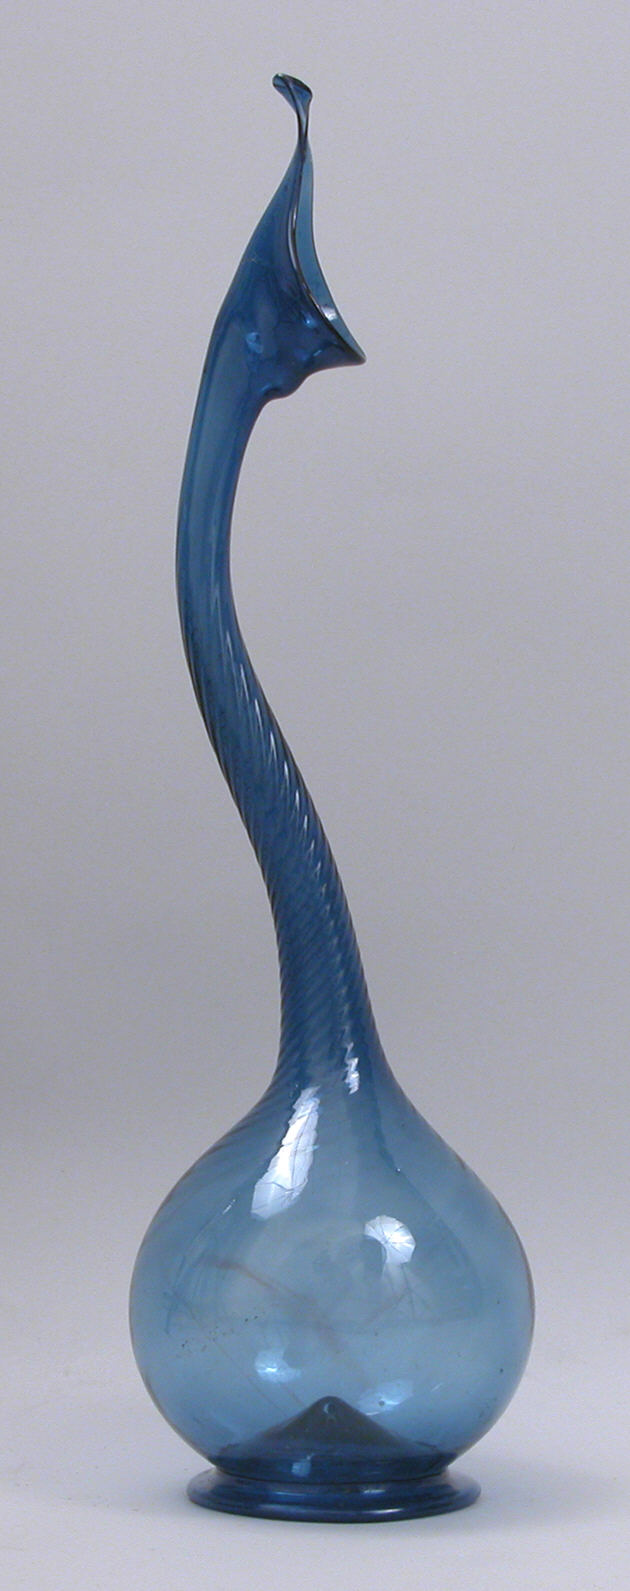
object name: bottle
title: Swan-Neck Bottle (Ashkdan)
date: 1701-1900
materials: glass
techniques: glassblowing, tooling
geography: iran